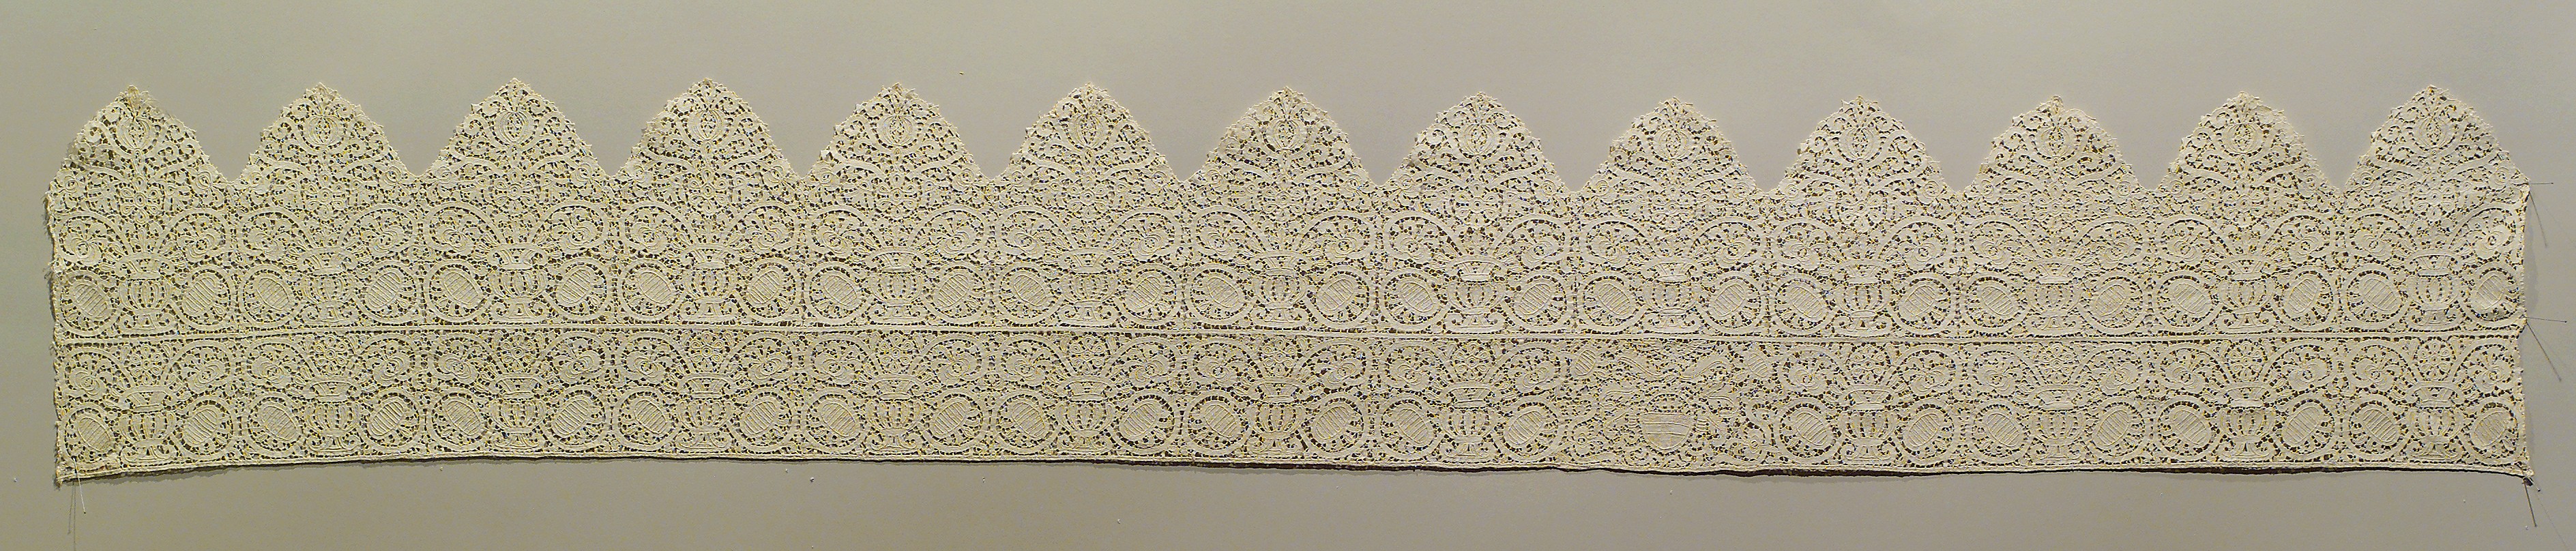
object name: flounce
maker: bartolomeo danieli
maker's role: artist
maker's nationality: italian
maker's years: 1610-1643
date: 1601-1700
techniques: lace